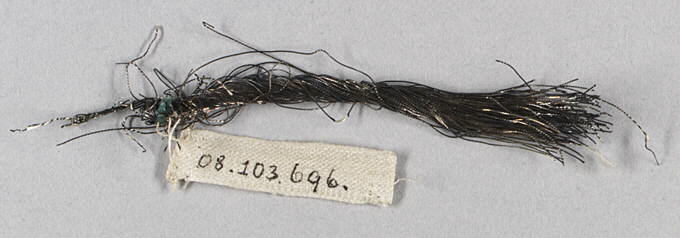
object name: thread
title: Tinsel and metal thread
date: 1701-1900